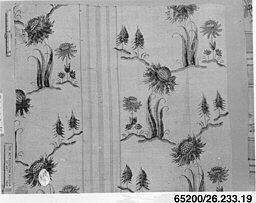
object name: fragment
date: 1801-1833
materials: cotton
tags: flowers,leaves